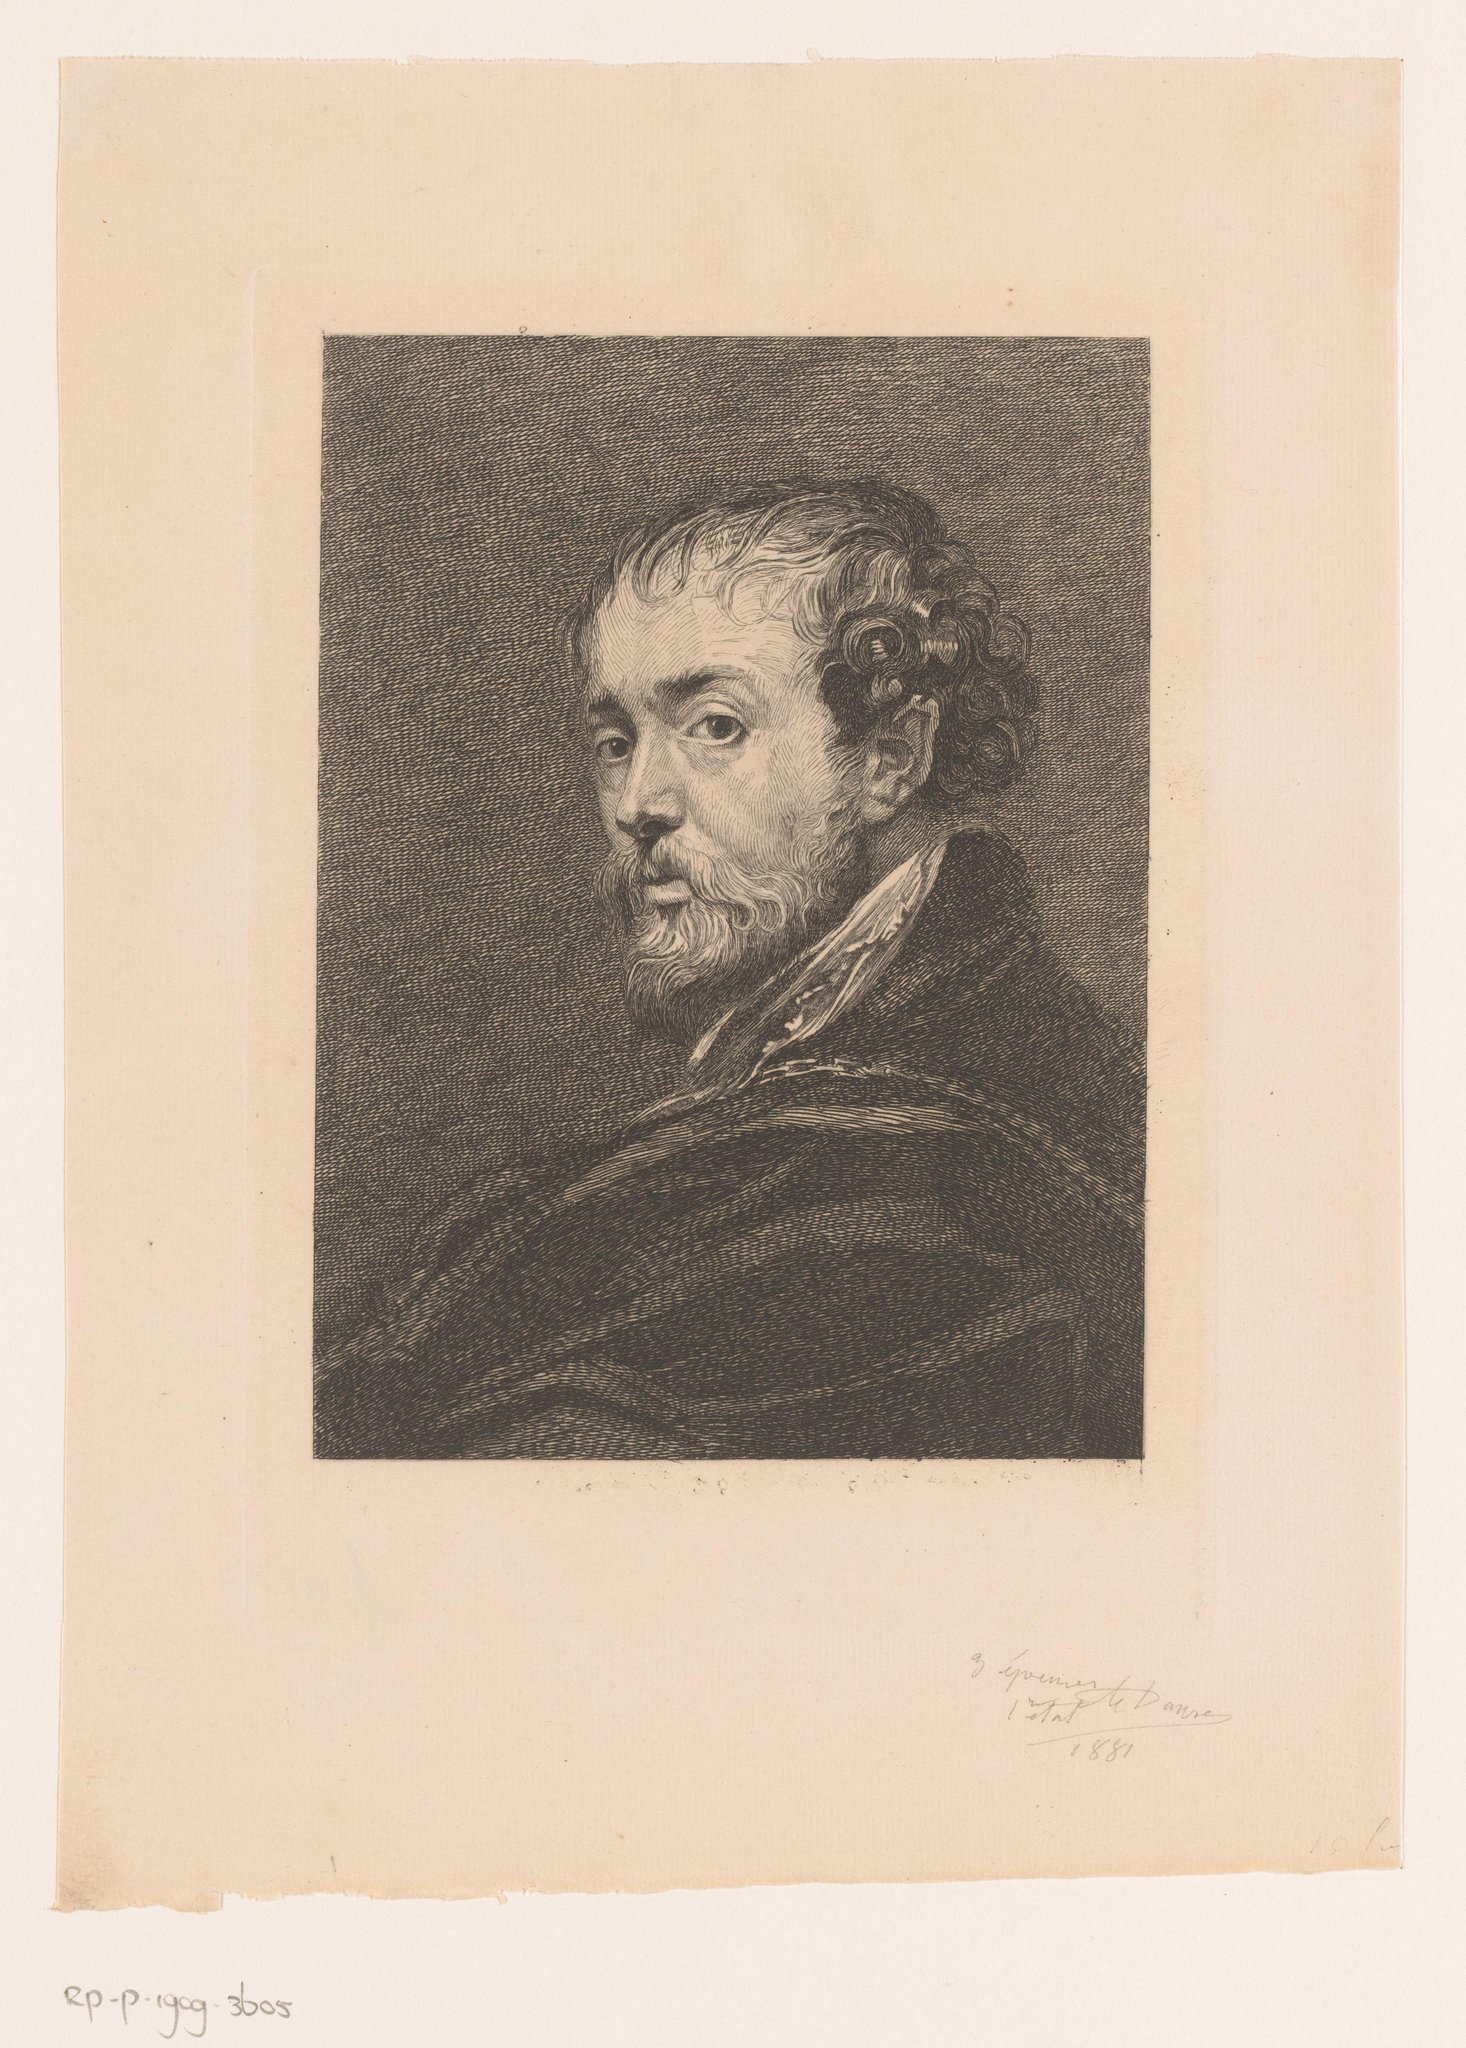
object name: print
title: Portret van Félix Nève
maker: auguste danse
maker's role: print maker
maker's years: 1829-1929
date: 1893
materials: paper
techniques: etching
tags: louvain, historical person (...) - historical person (...) portrayed alone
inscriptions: annotation: ‘2m état’, collector's mark: Lugt 2228